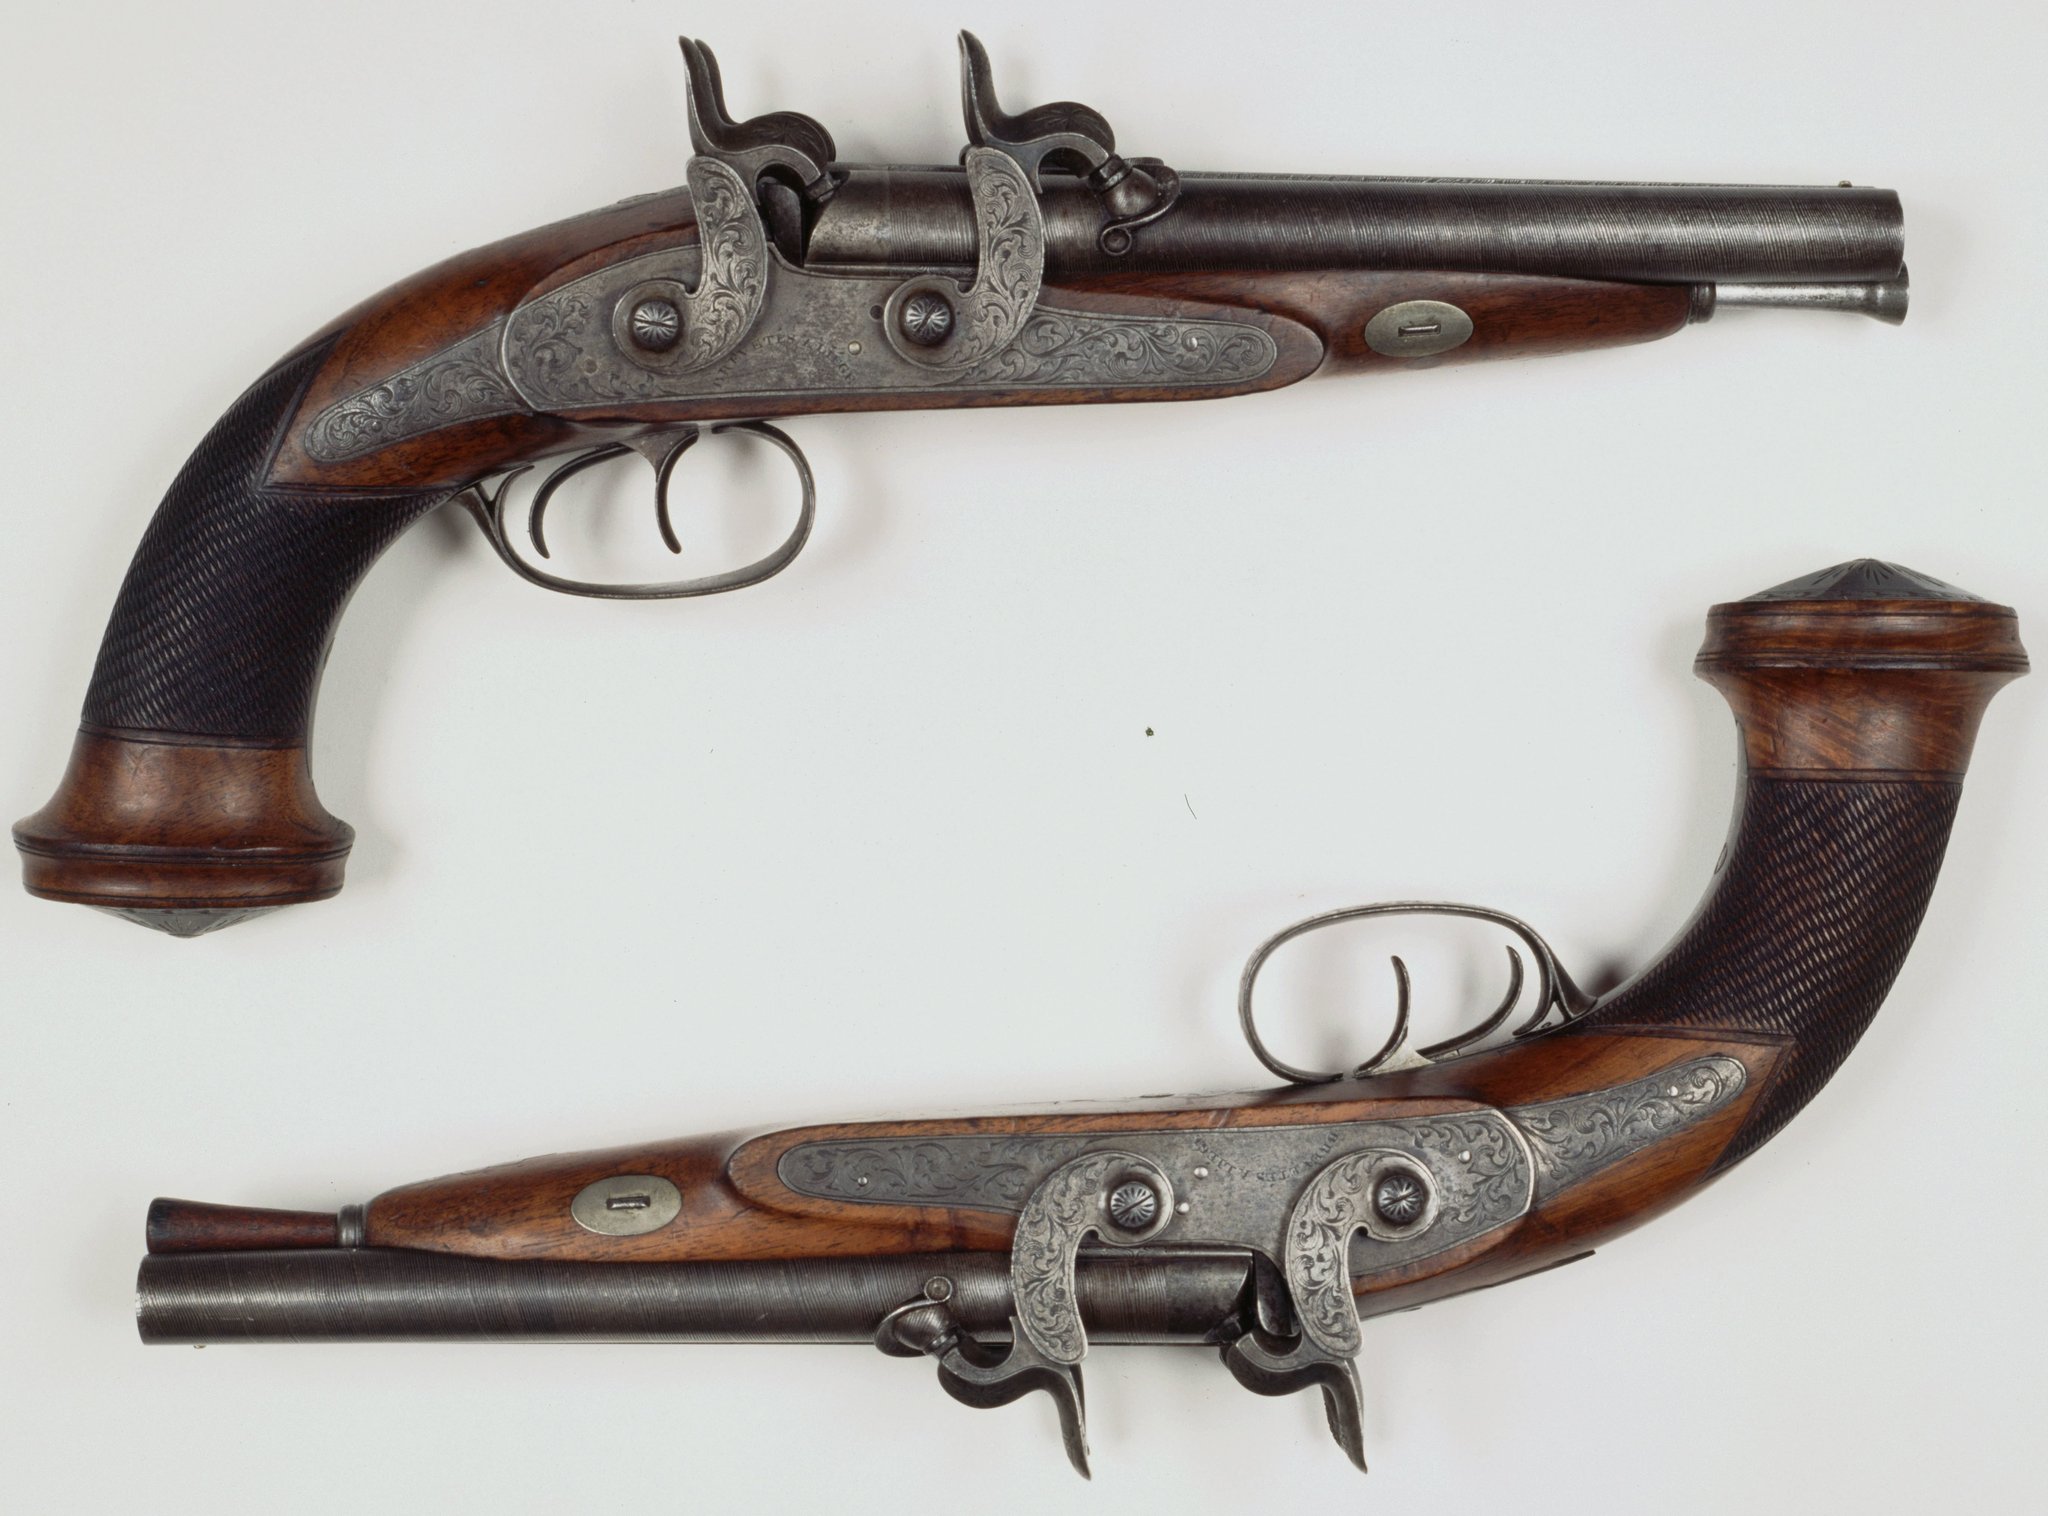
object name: percussion pistol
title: Percussiepistool met twee lopen en vier hanen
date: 1844-1862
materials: iron, wood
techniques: cutting, metalworking, engraving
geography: liège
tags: netherlands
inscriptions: mark: ‘De Walle Frères . Brevetés à Liège’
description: Percussiepistool met twee ijzeren ronde naast elkaar gelegen gedamasceerde lopen. Vier ijzeren met lofwerk gegraveerde hanen. De slotplaat is van ijzer en gegraveerd met lofwerk. Een houten kolf waar de greep van is bewerkt. Een ijzeren kolfkap welke is gegraveerd met lofwerk. De trekkerbeugel is van ijzer en is van onderen geheel gegraveerd met lofwerk. Twee trekkers waarvan de achterste langer is dan de voorste trekker. De lade is geheel van hout. Onder de lopen een laadstokkoker waarin een ijzeren laadstok zit. Onder de opening van de laadstok een kleine gegraveerde metalen plaat. Gemerkt op de linkerslotplaat DEWALLE FRèRES; gemerkt op de rechterslotplaat BRÉVETÉS A LIÉGE.